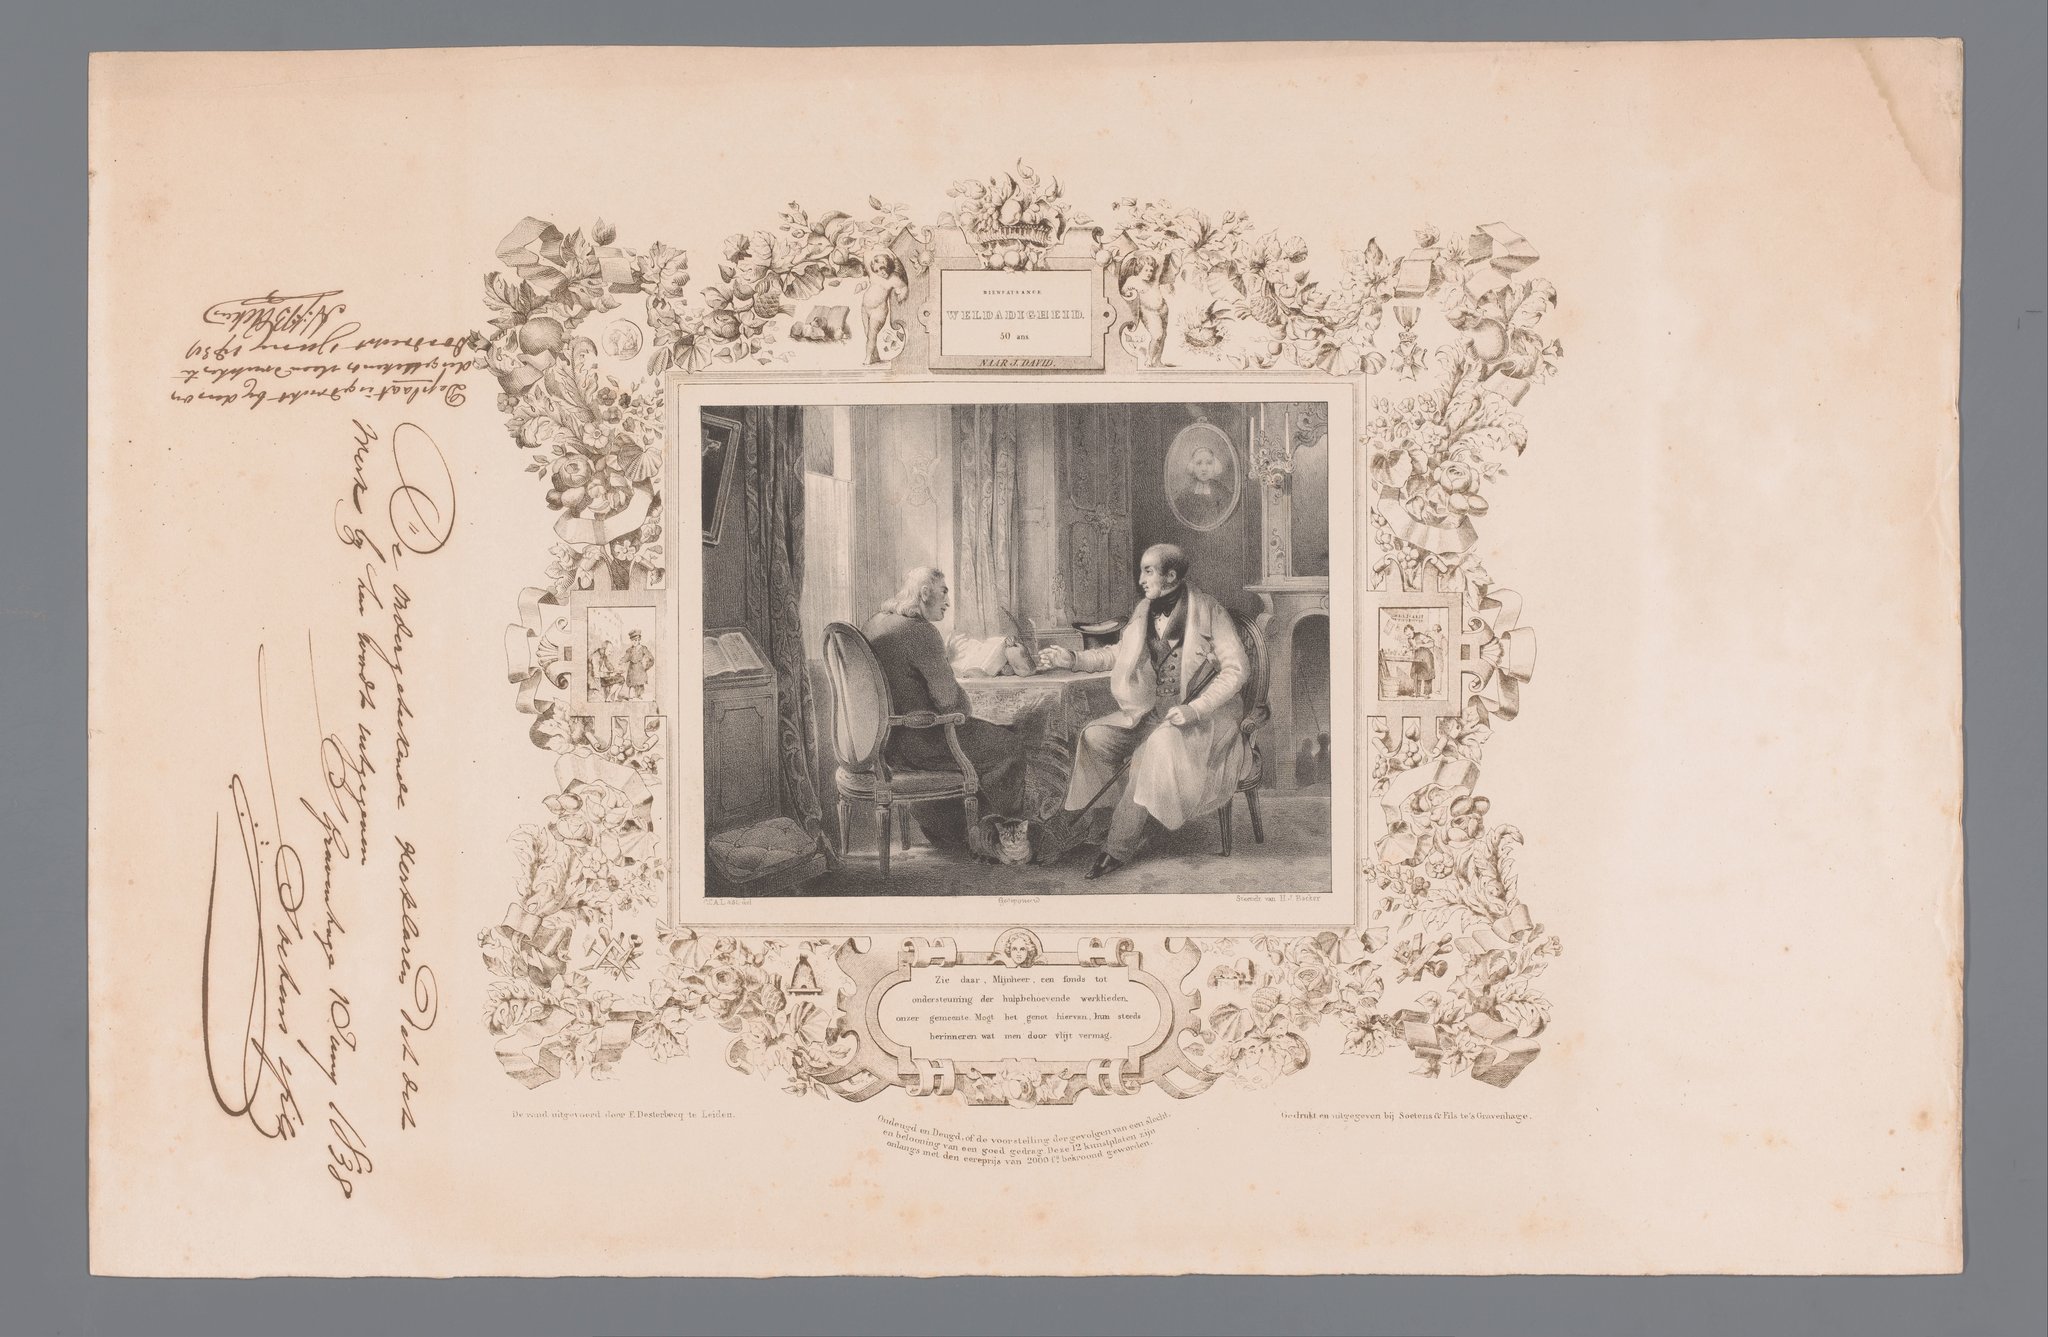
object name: print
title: Man schenkt geldbedrag aan een geestelijke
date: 1837-1840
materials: paper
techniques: lithograph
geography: the hague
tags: unselfishness (+ situation or event (especially in genre-painting) with symbolical connotation), virtuousness; 'amor di virtù', 'attione virtuosa', 'guida sicura de' veri honori', 'virtù', 'virtù insuperabile' (ripa), giving alms; collection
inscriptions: : ‘De plaat is gedrukt bij den on / dergetekenden steendrukkers te / Dordrecht 1 juny 1838 / H. J. Backer’, : ‘Gedeponeerd’, collector's mark: Lugt 2228, : ‘De ondergetekende verklaren dat het / werk bij hen wordt uitgegeven / S Gravenhage 1 Juny 1838 / Soetens Fils’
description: De vijftigjarige man heeft een zak geld meegenomen die tussen de twee mannen op tafel ligt. Volgens de beschrijving op de omslag heeft hij zijn hele leven gespaard. Hij vraagt de eerwaarde dit geld uit te delen aan arme arbeiders. In de rand symbolen die verwijzen naar deugd zoals het geven van een aalmoes, noeste arbeid en een ridderorde. Maakt deel uit van een omslag met zes prenten.